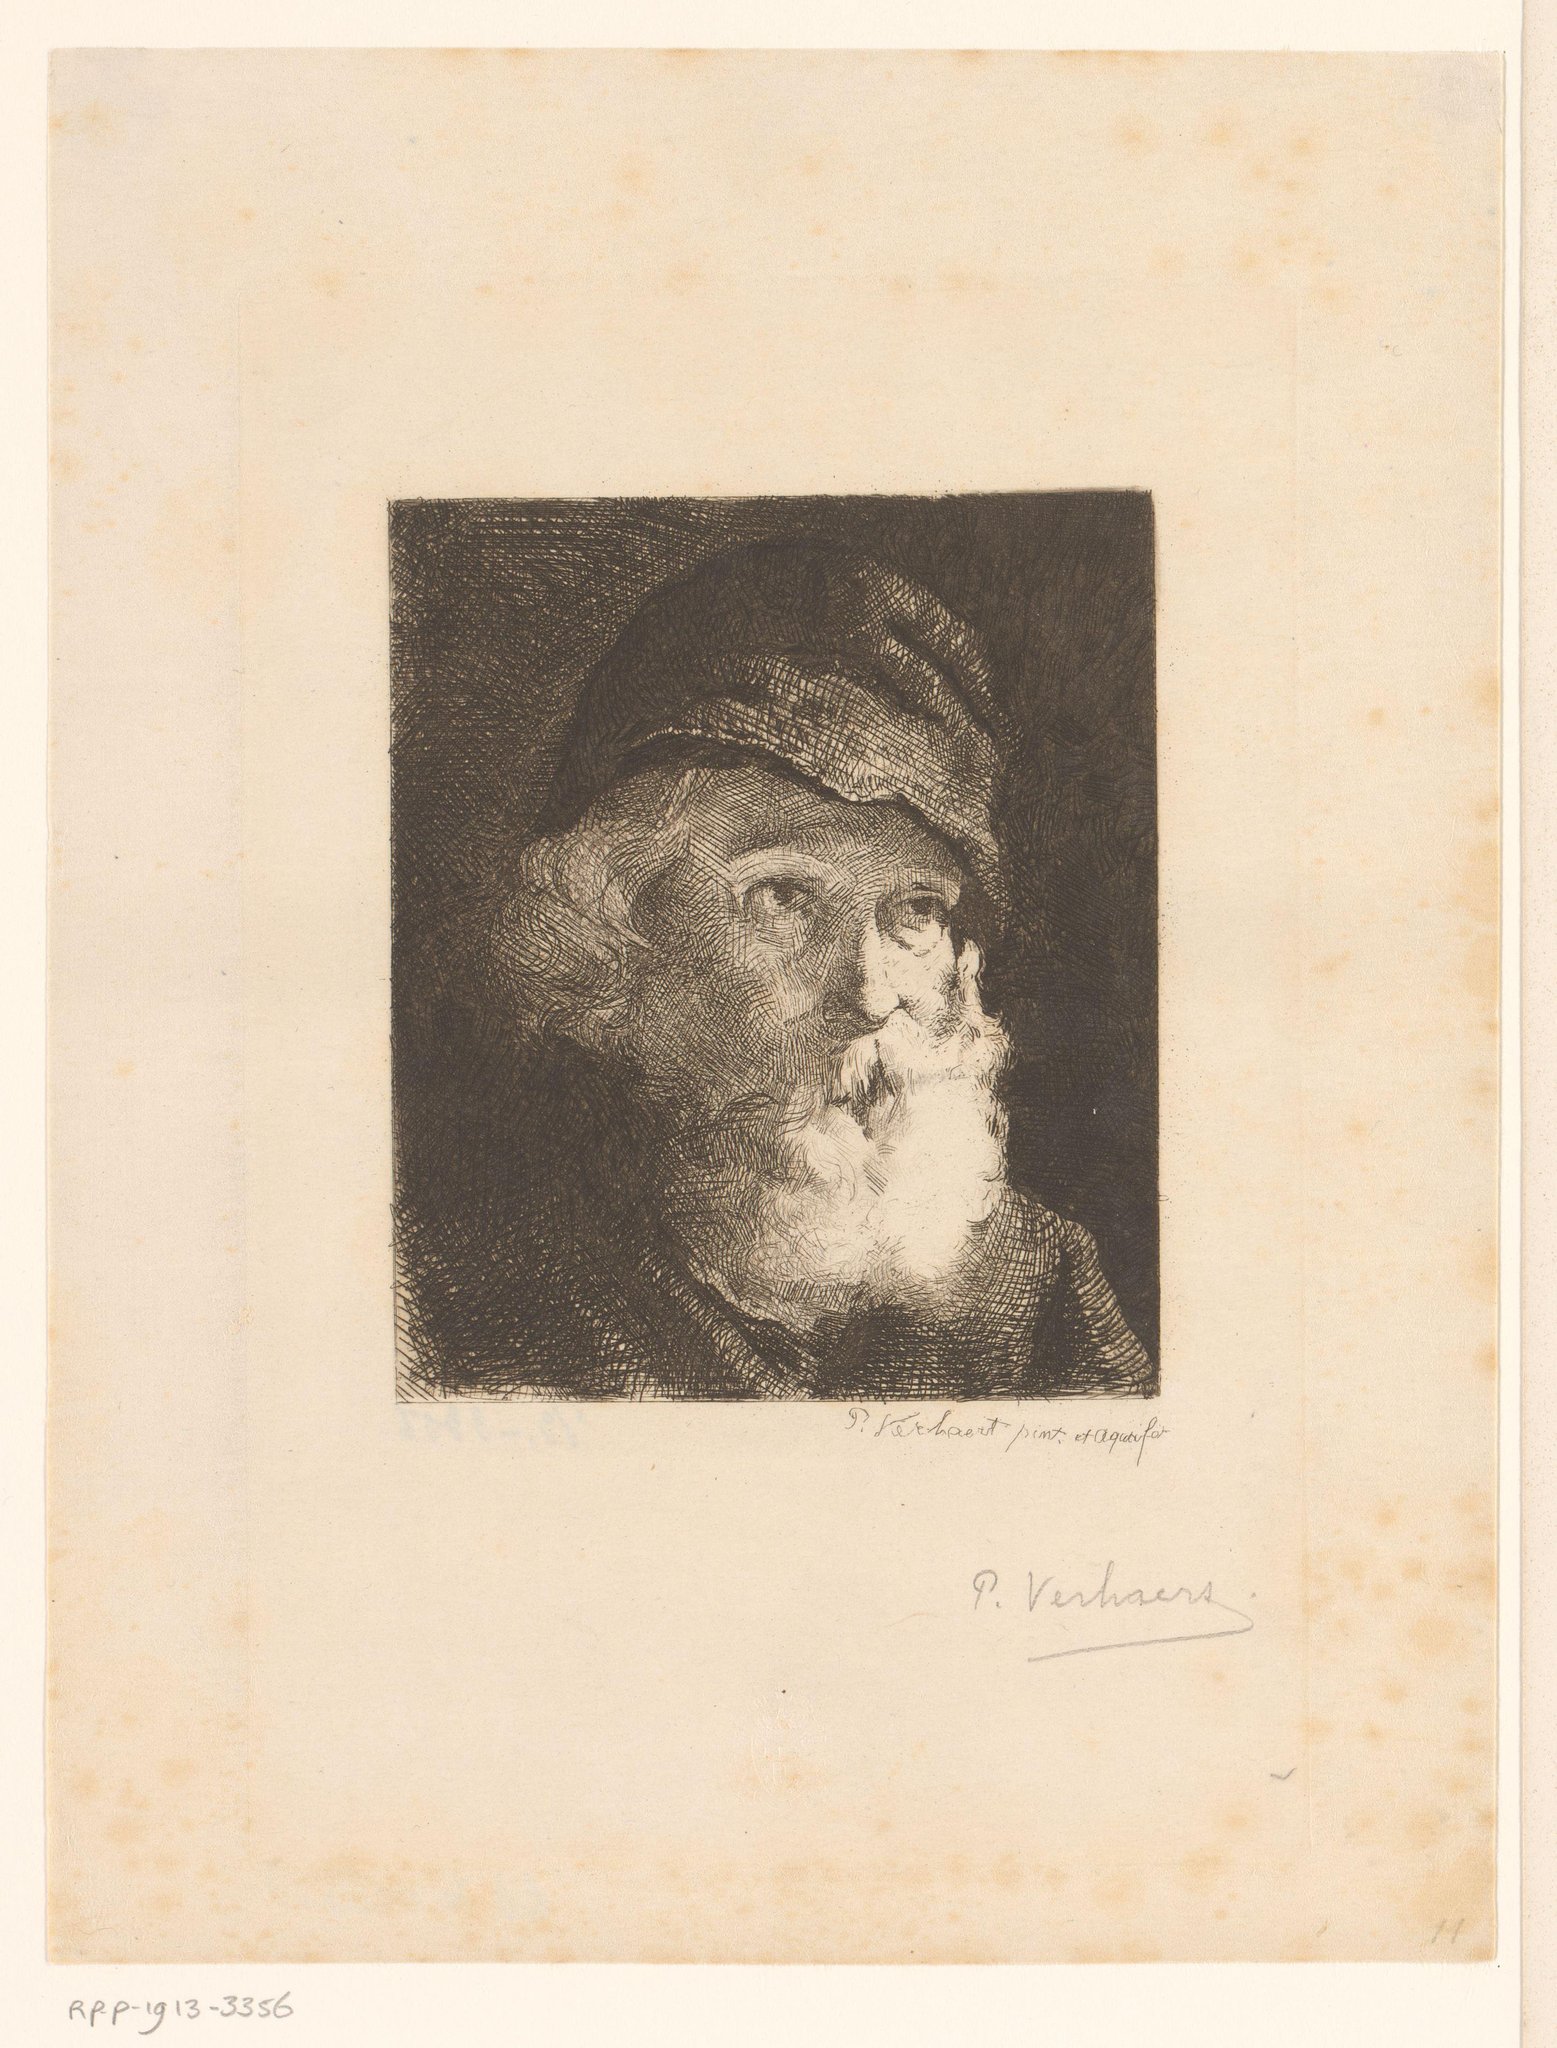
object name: print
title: Portret van Charles Sluijt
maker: piet verhaert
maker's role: print maker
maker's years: 1852-1908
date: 1883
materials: paper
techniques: etching, retroussage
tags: head-gear, adult man, historical persons, beard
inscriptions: collector's mark: Lugt 2228, mark: ‘Antwerpsche Etsers 1880’